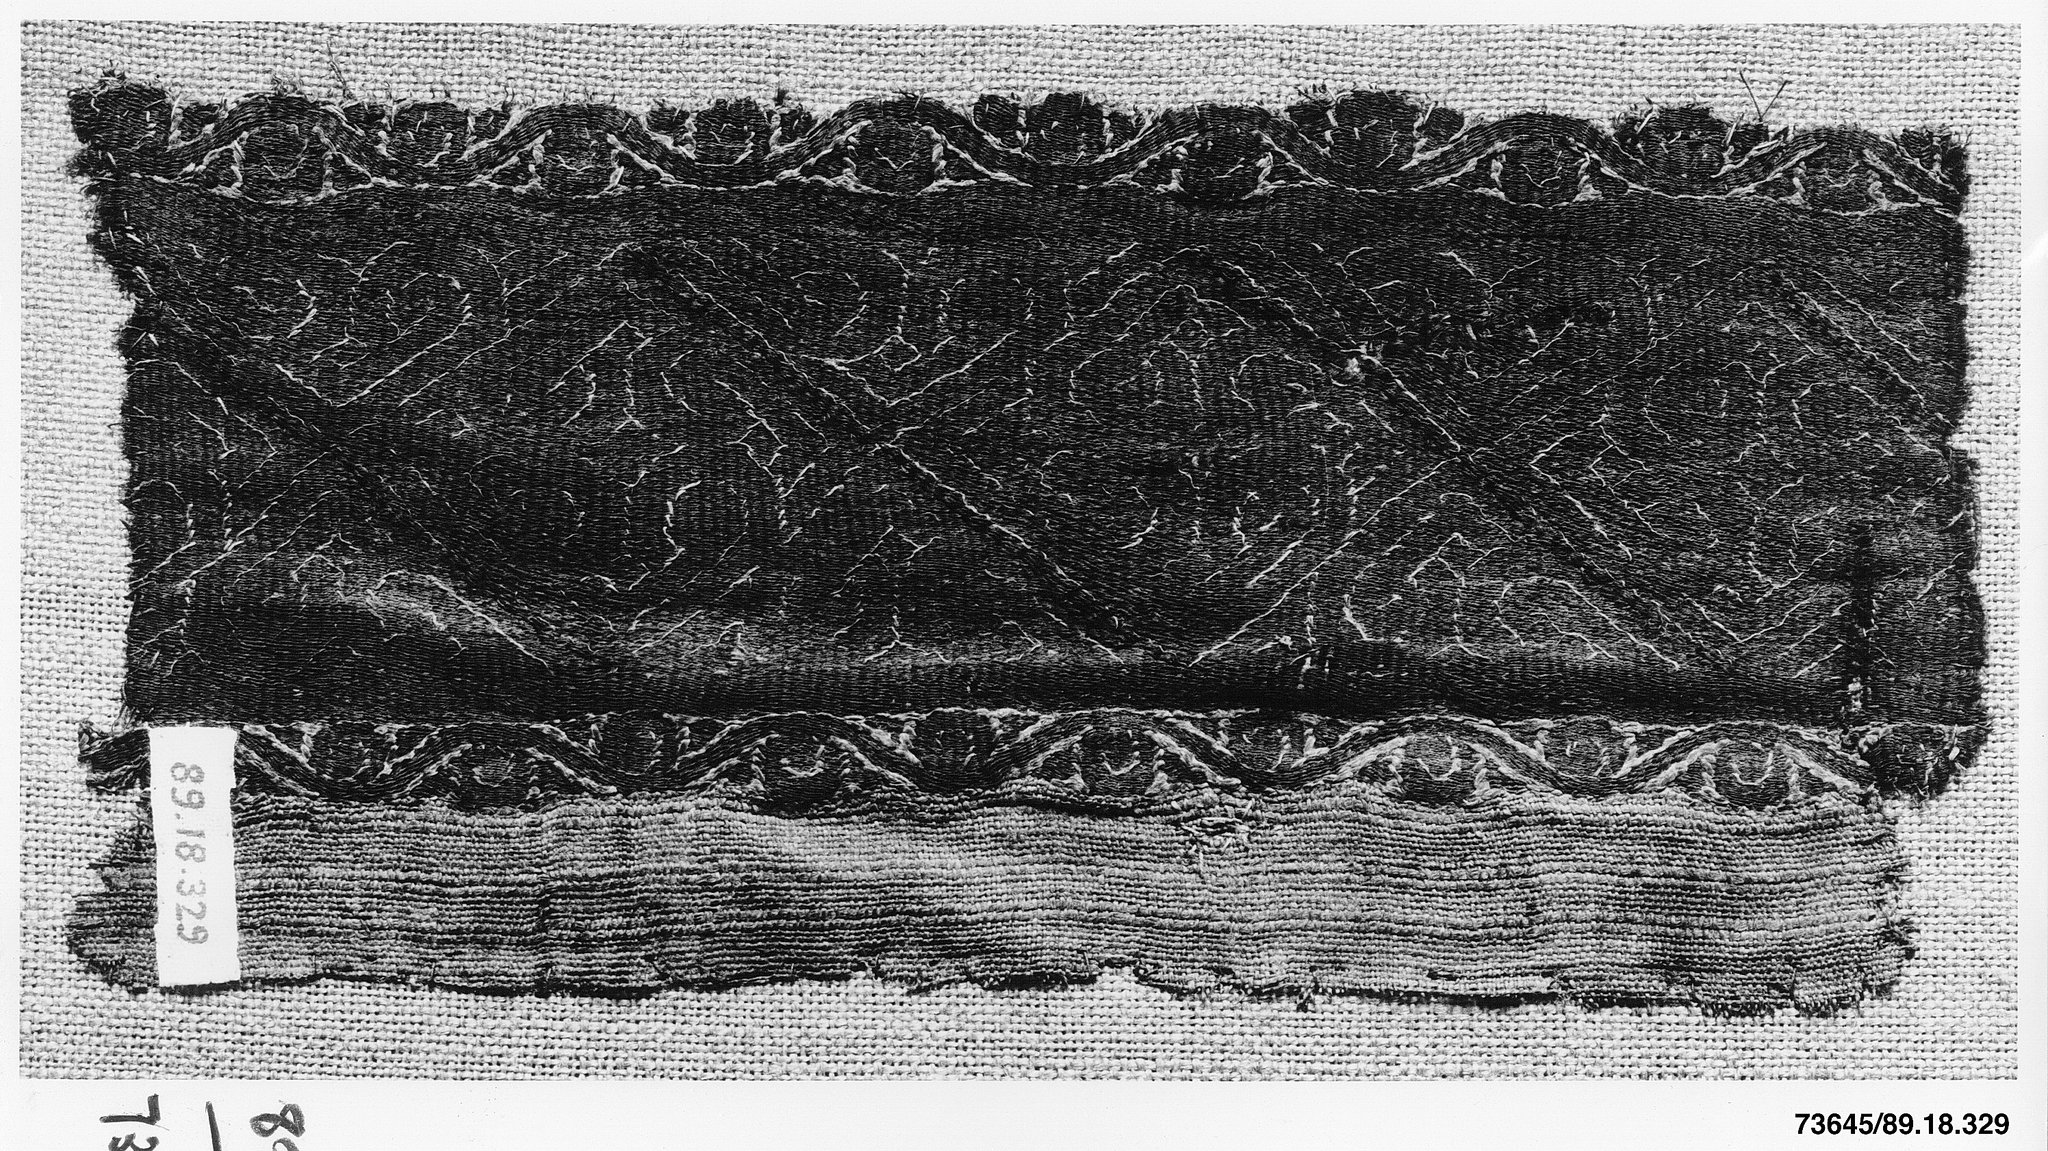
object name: textile fragment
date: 201-400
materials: linen, wool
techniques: weave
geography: egypt